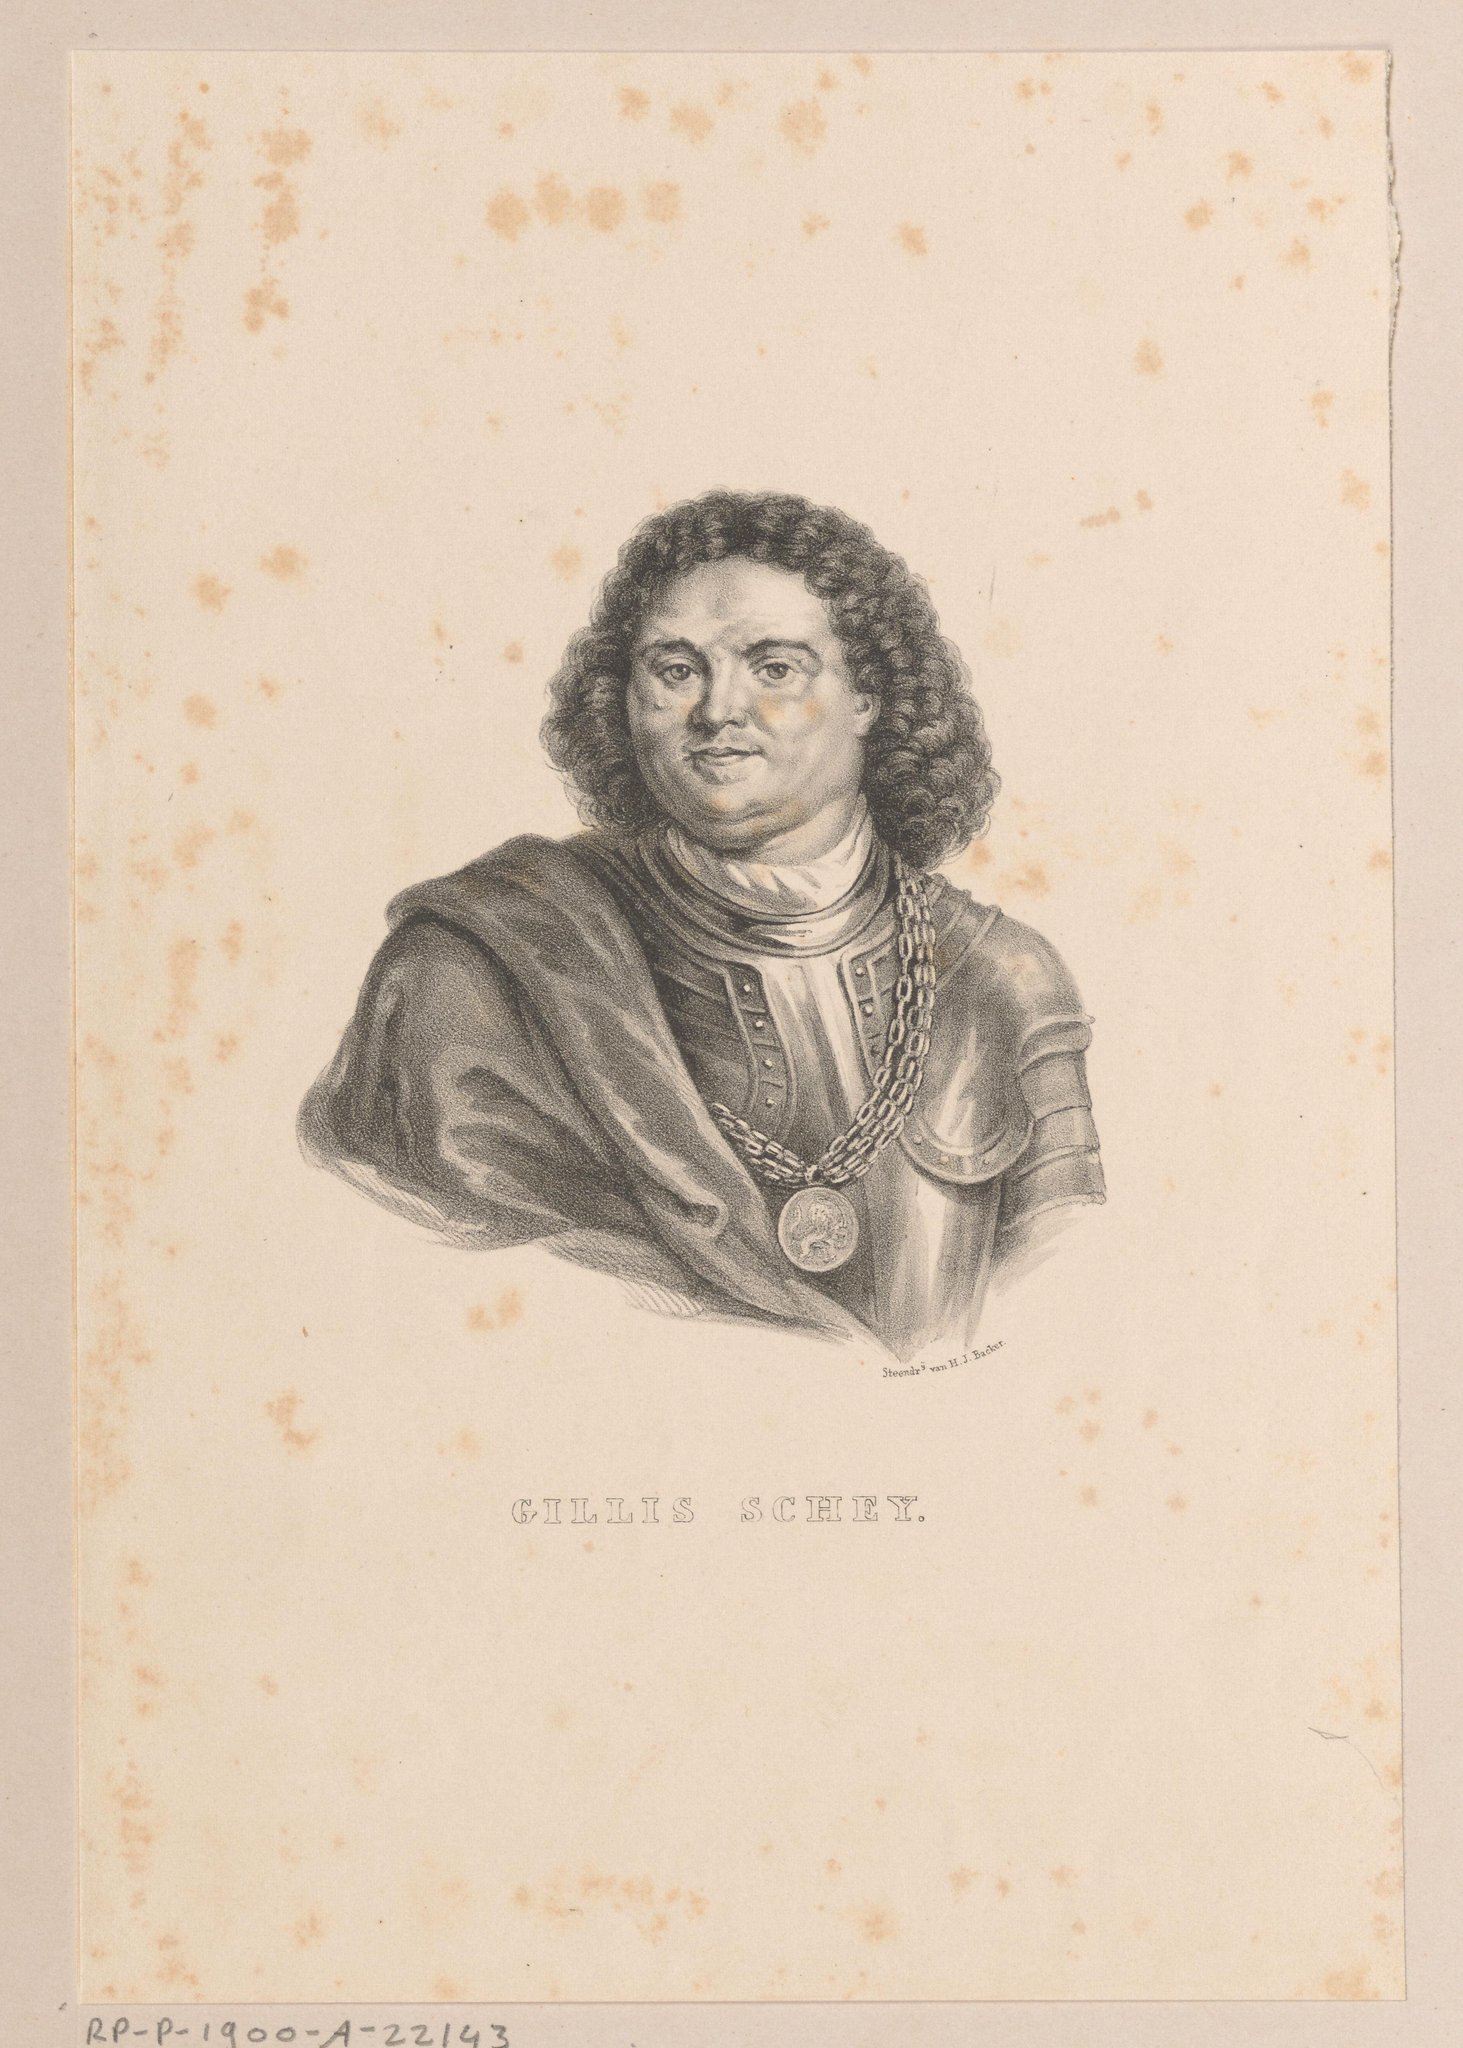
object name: print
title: Portret van Gilles Schey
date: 1833-1845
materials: paper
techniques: lithograph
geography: dordrecht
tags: historical persons, commander-in-chief, admiral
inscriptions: collector's mark: Lugt 2228